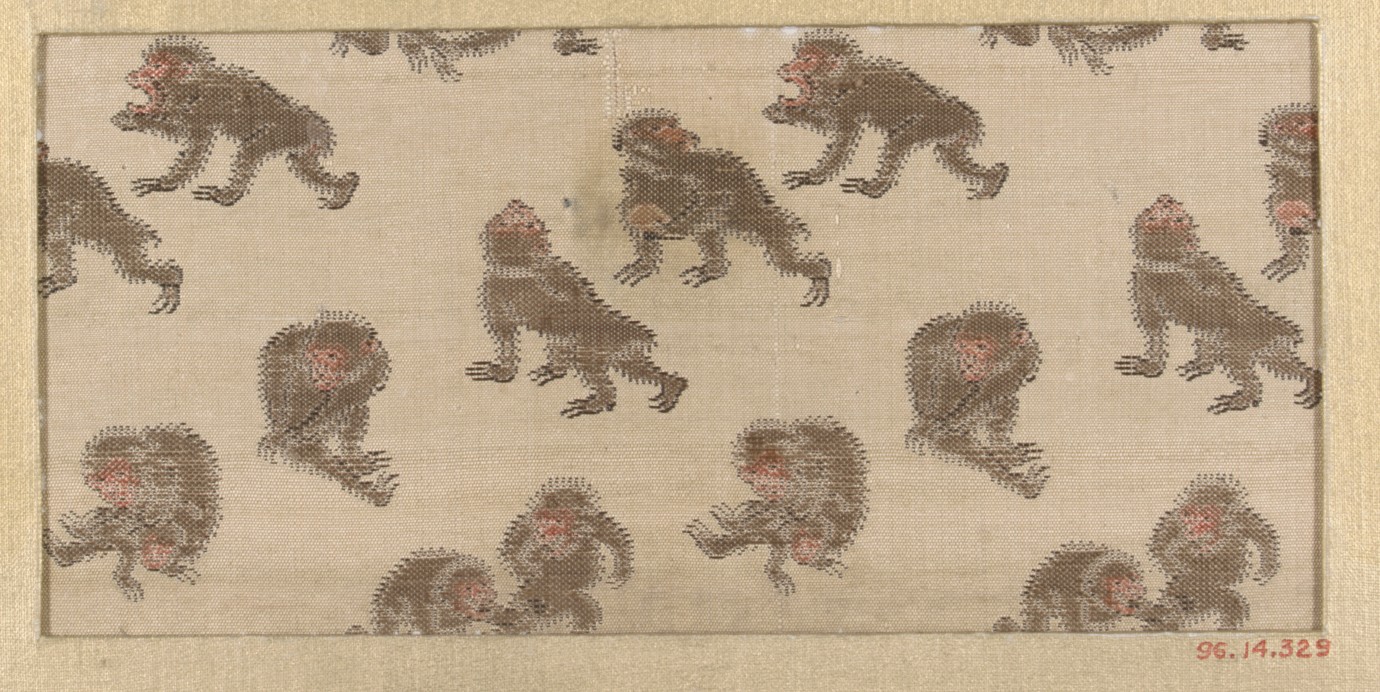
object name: piece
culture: japanese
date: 1701-1900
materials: silk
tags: monkeys